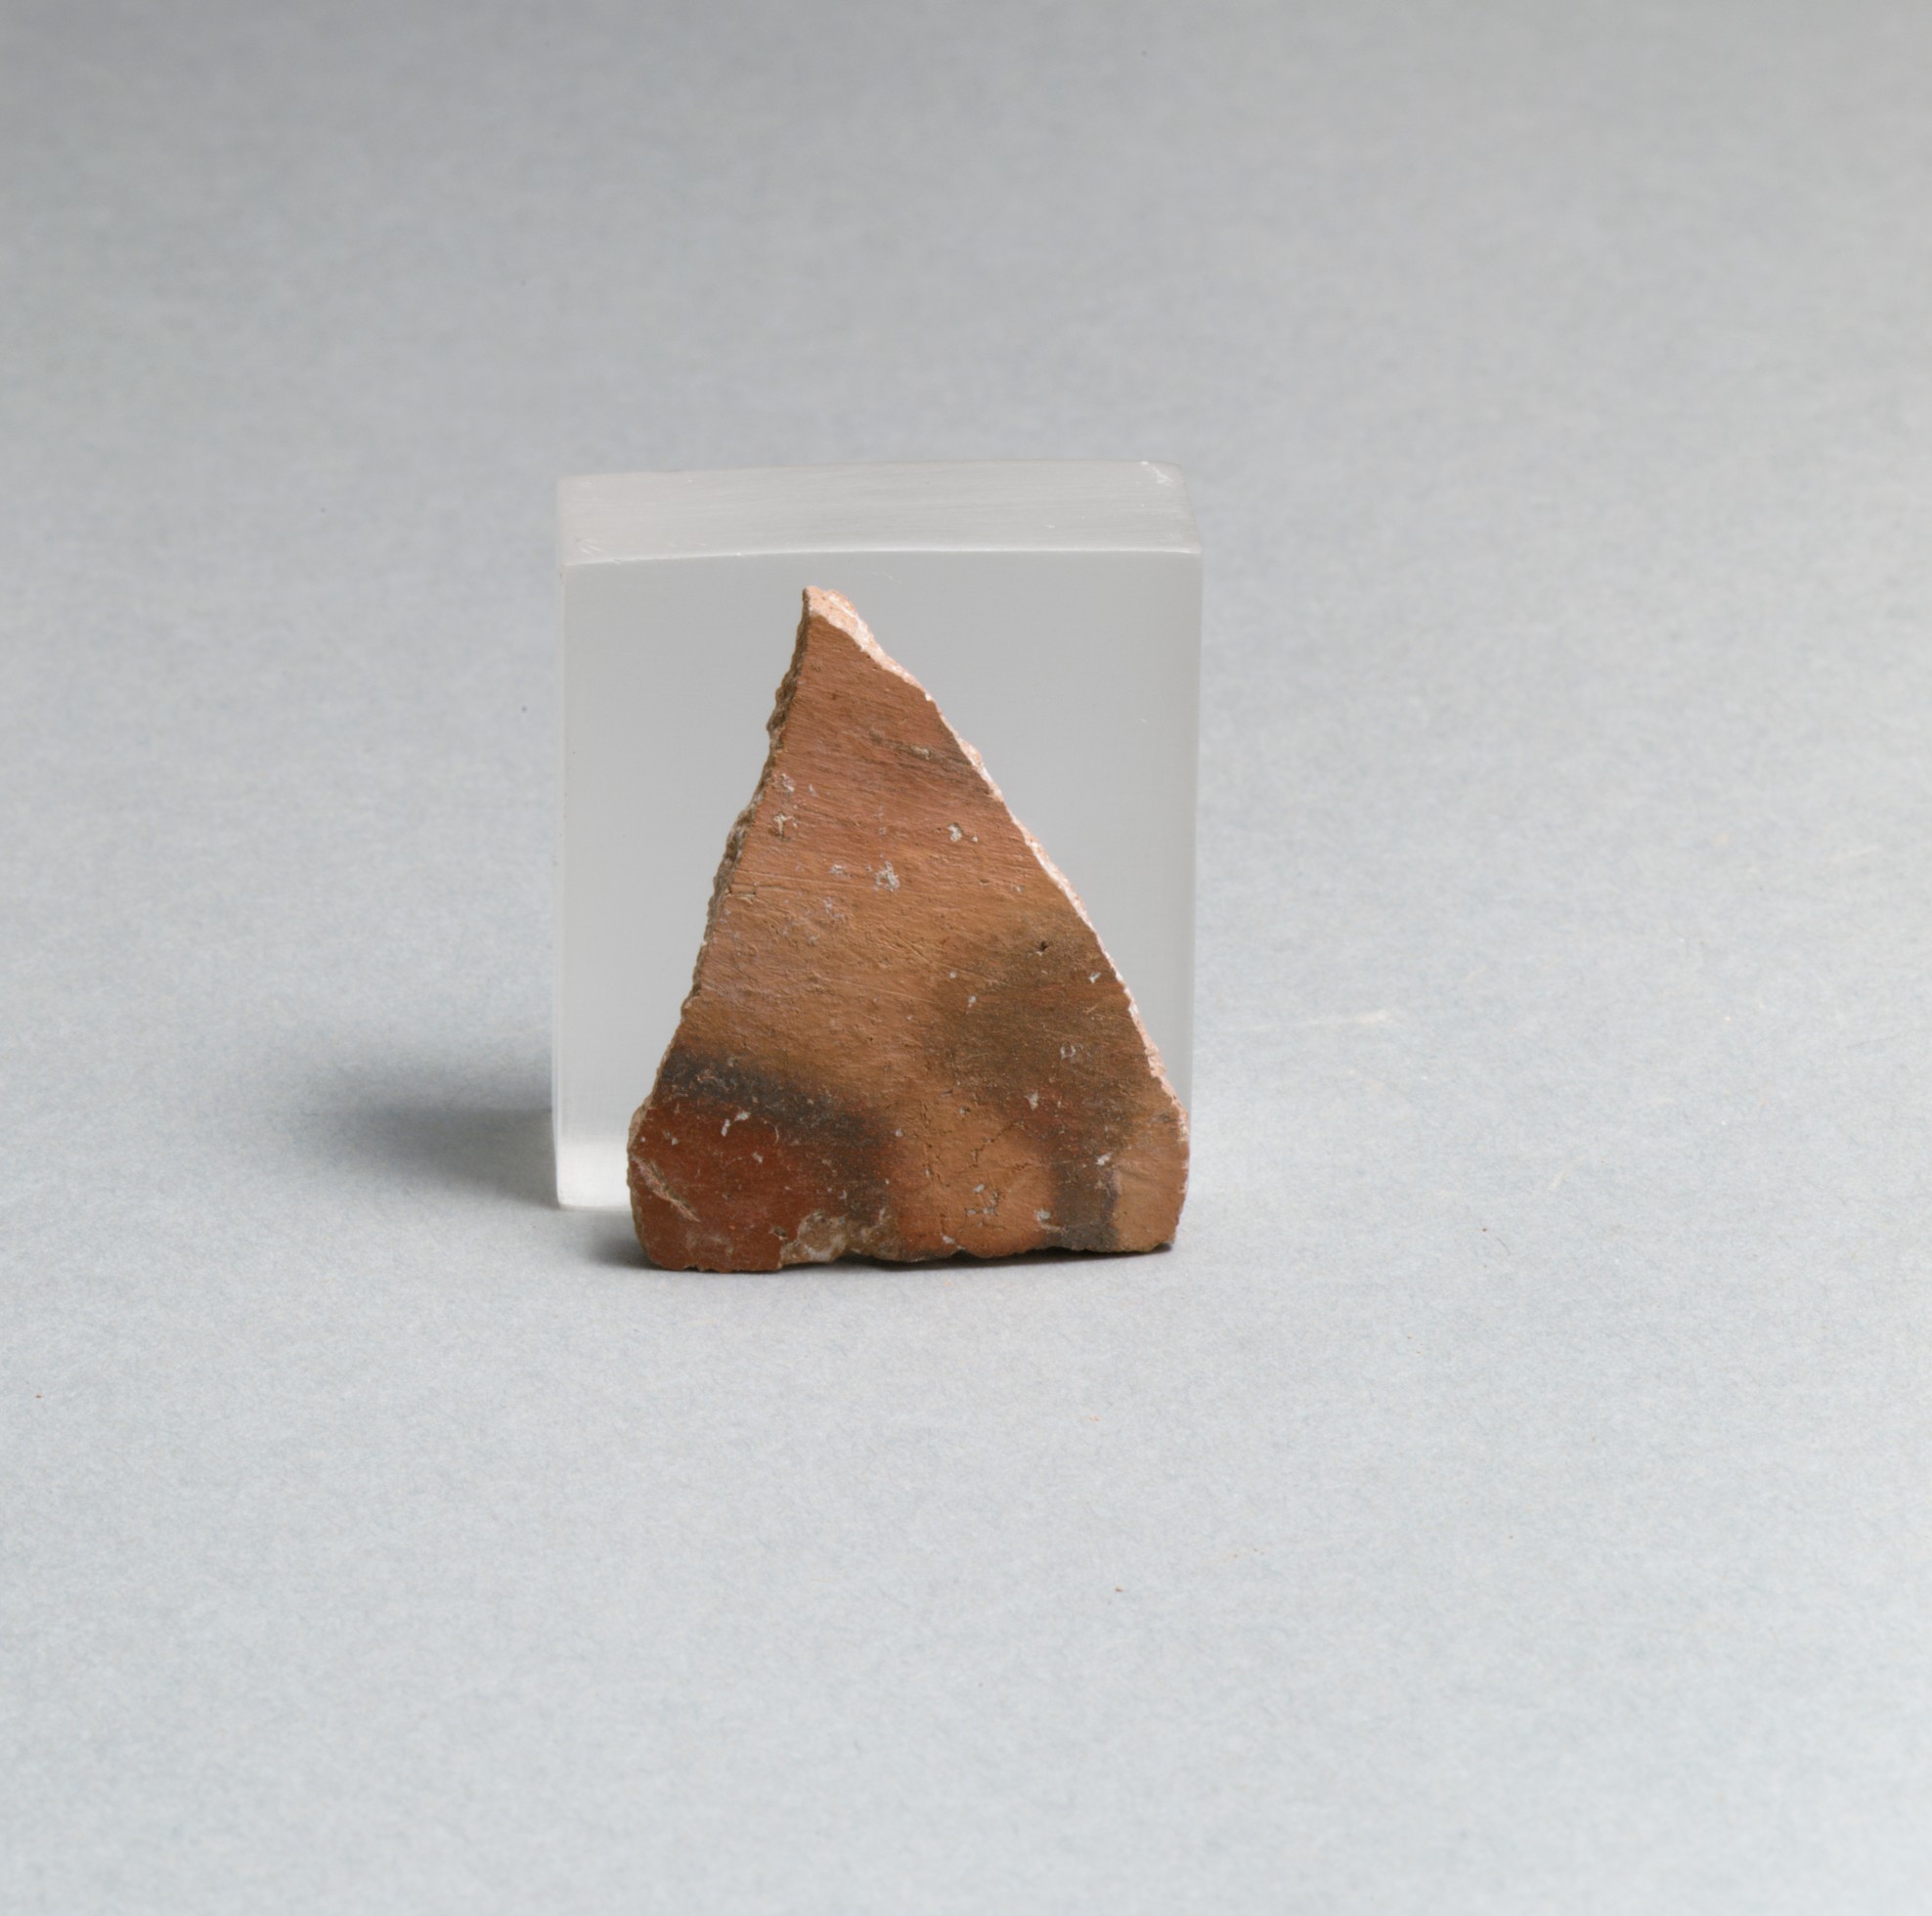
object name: vase fragment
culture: minoan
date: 2600-2000 BCE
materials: terracotta